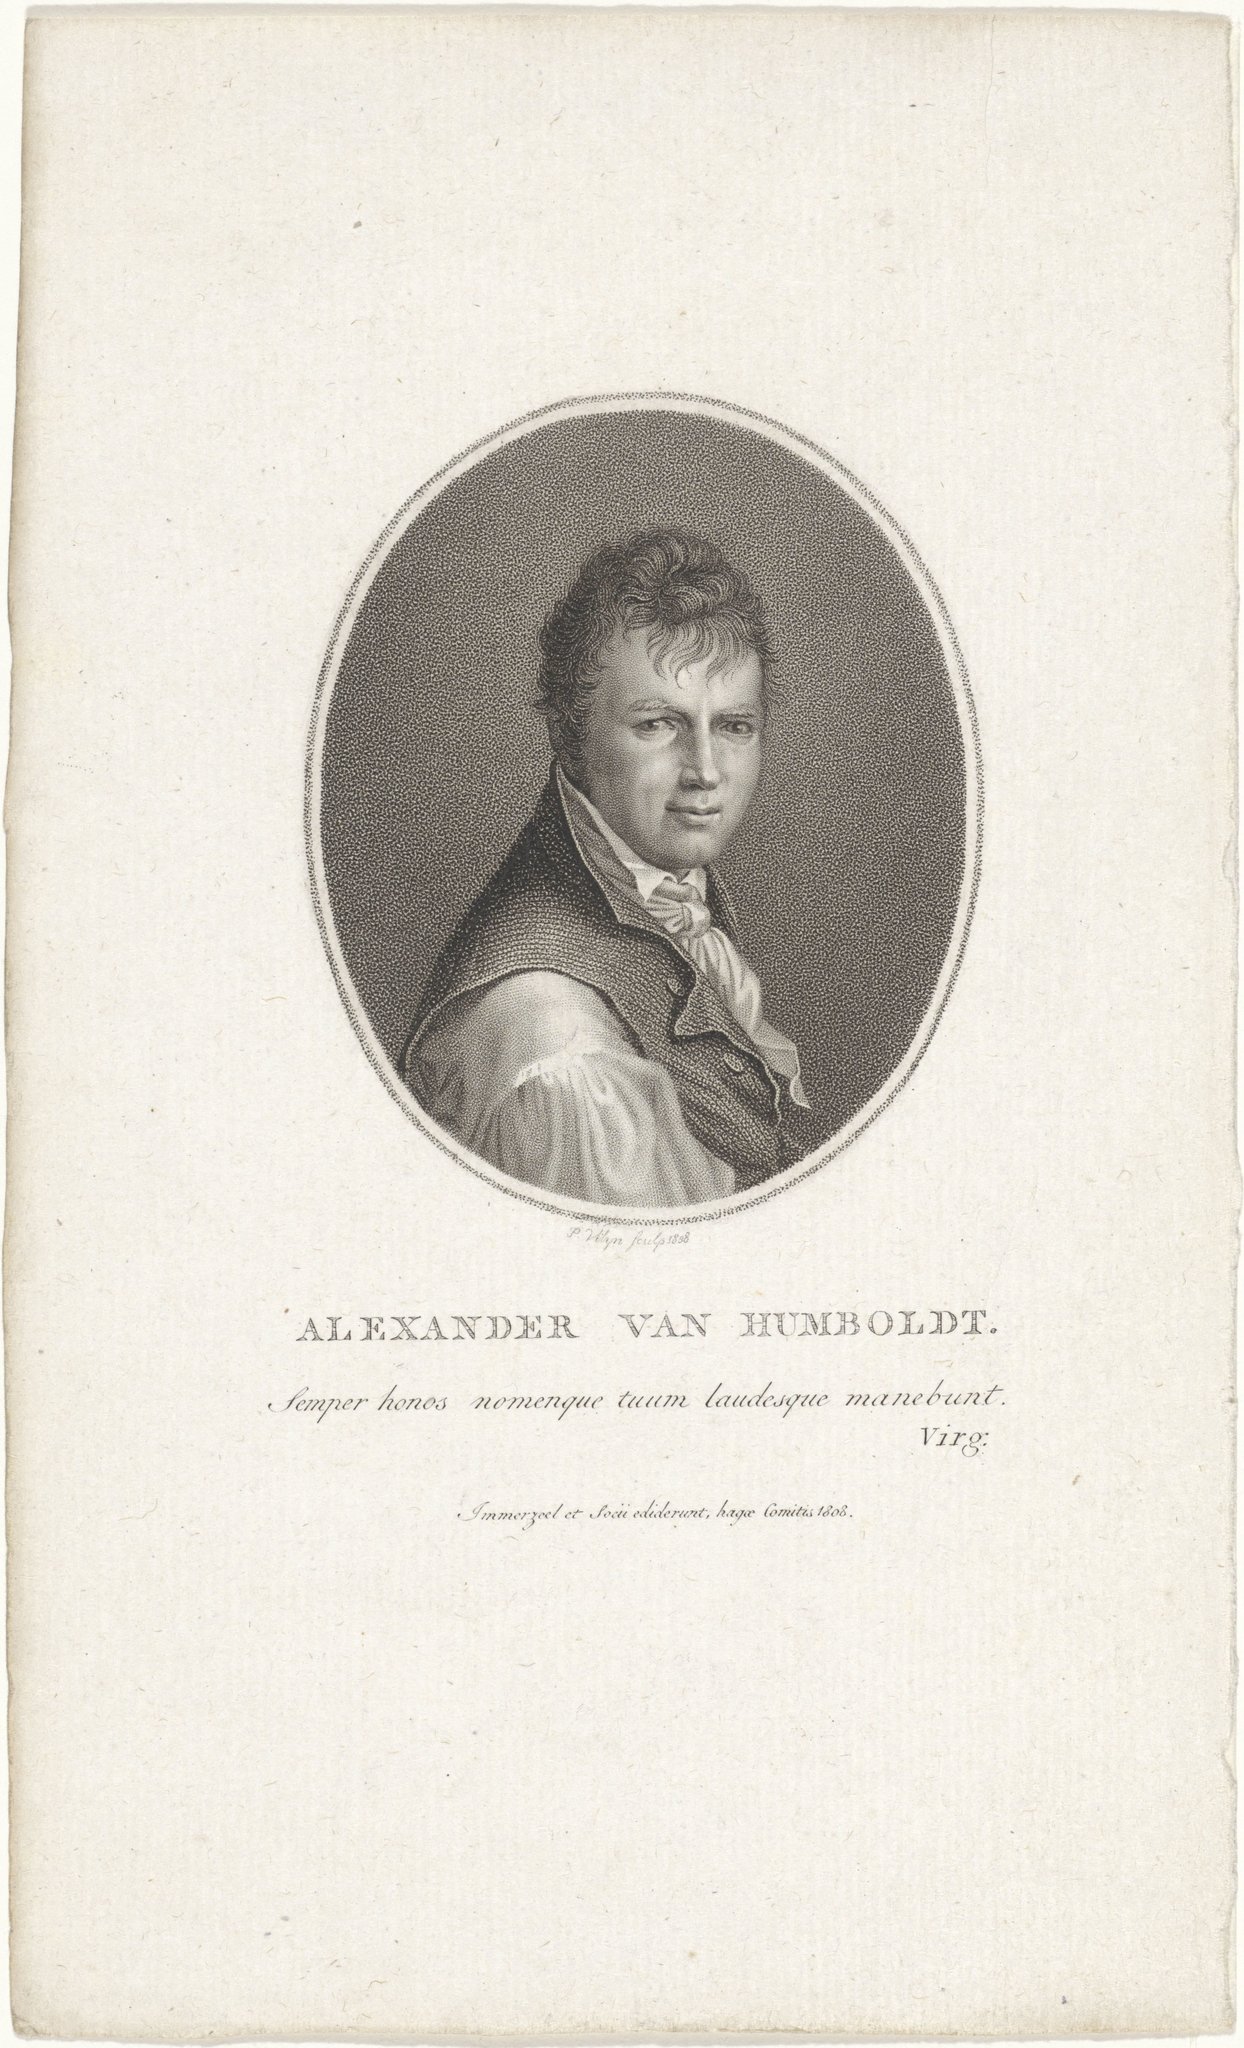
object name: print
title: Portret van Alexander van Humboldt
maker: philippus velijn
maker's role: print maker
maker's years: 1787-1836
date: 1808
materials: paper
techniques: engraving, etching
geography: the hague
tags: berlin, traveler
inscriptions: collector's mark: Lugt 2228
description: Portret van Alexander van Humboldt, natuurkundige en botanicus.